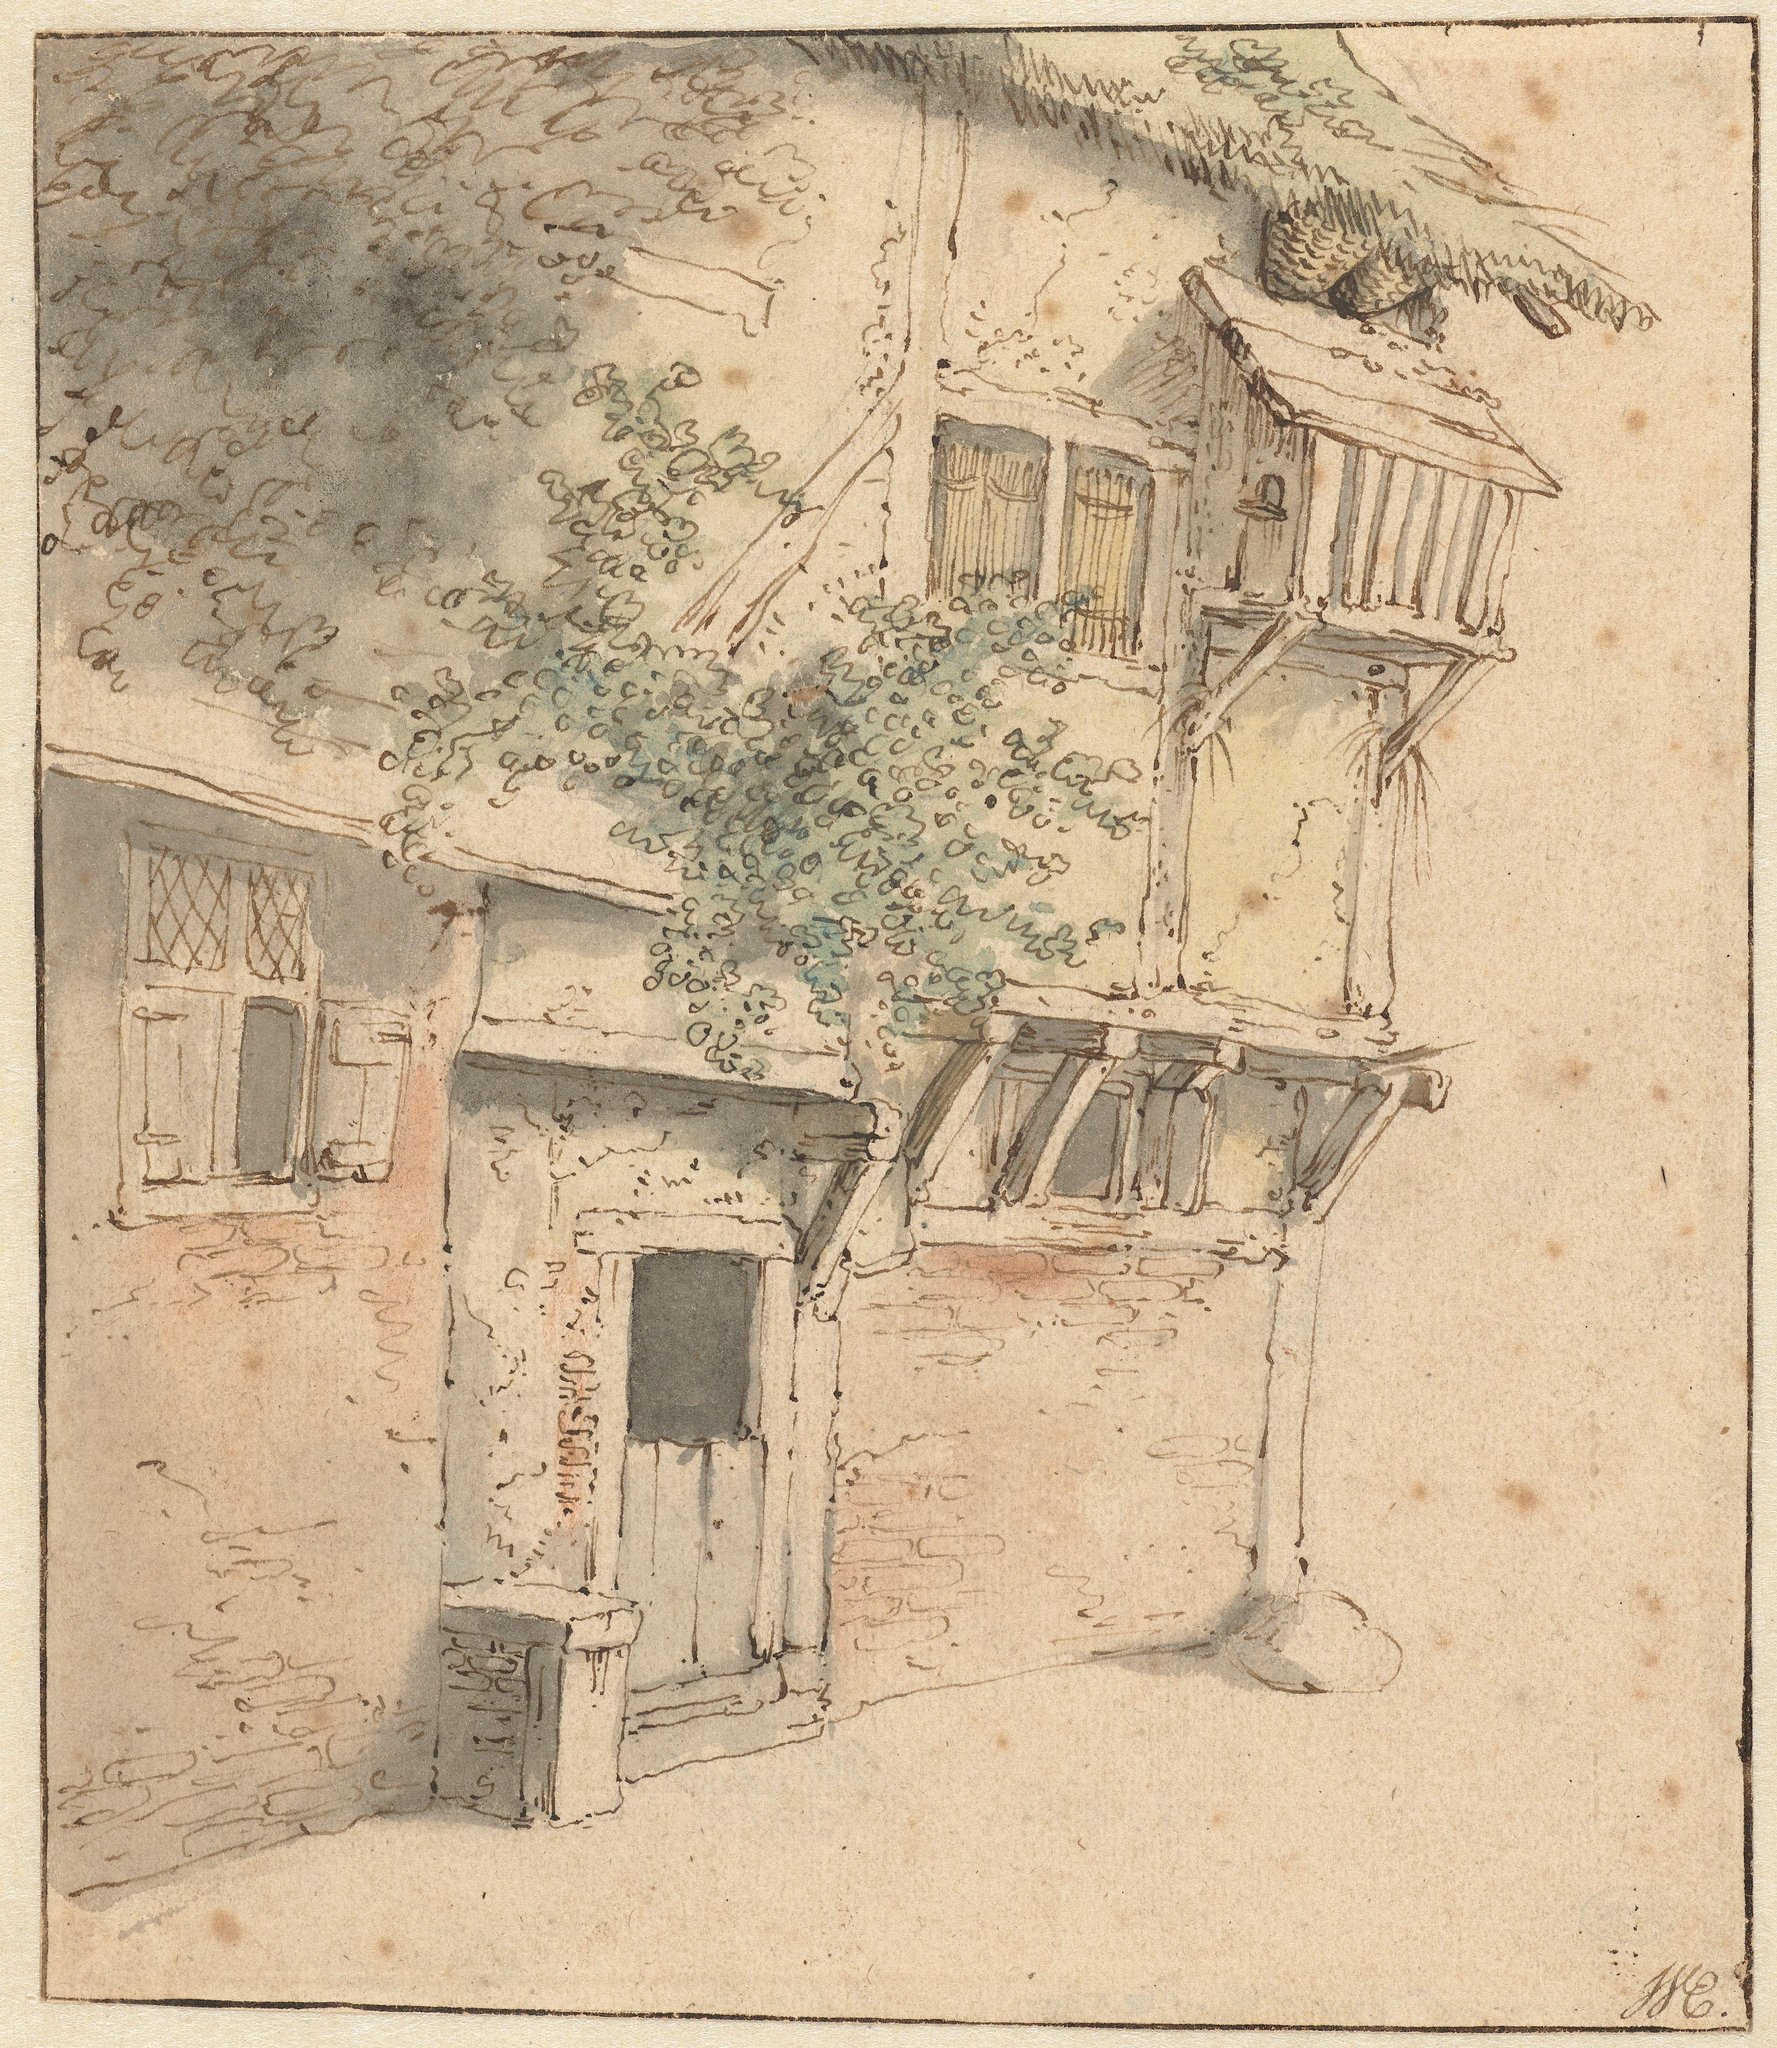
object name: drawing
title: Gevel van een begroeid huis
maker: isaac van ostade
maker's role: draughtsman, painter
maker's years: 1621-1649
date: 1645-1655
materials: ink, paper, pencil, watercolor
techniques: brush, pen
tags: façade (of house or building)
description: Gevel van een begroeid huis met een bankje naast de deur.